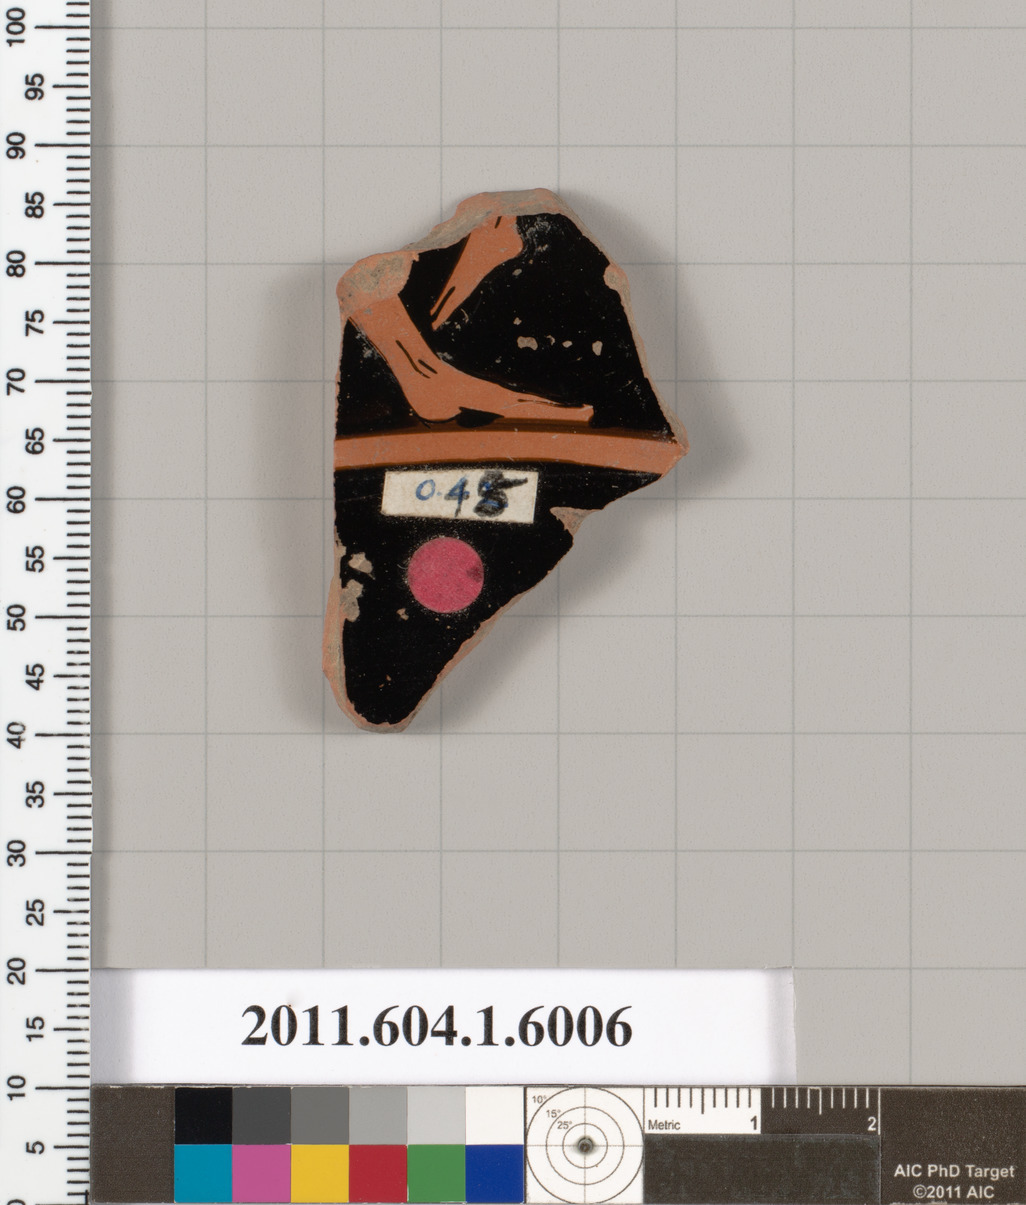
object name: kylix fragment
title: Terracotta fragment of a kylix (drinking cup)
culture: greek, attic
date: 510-500 BCE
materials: terracotta